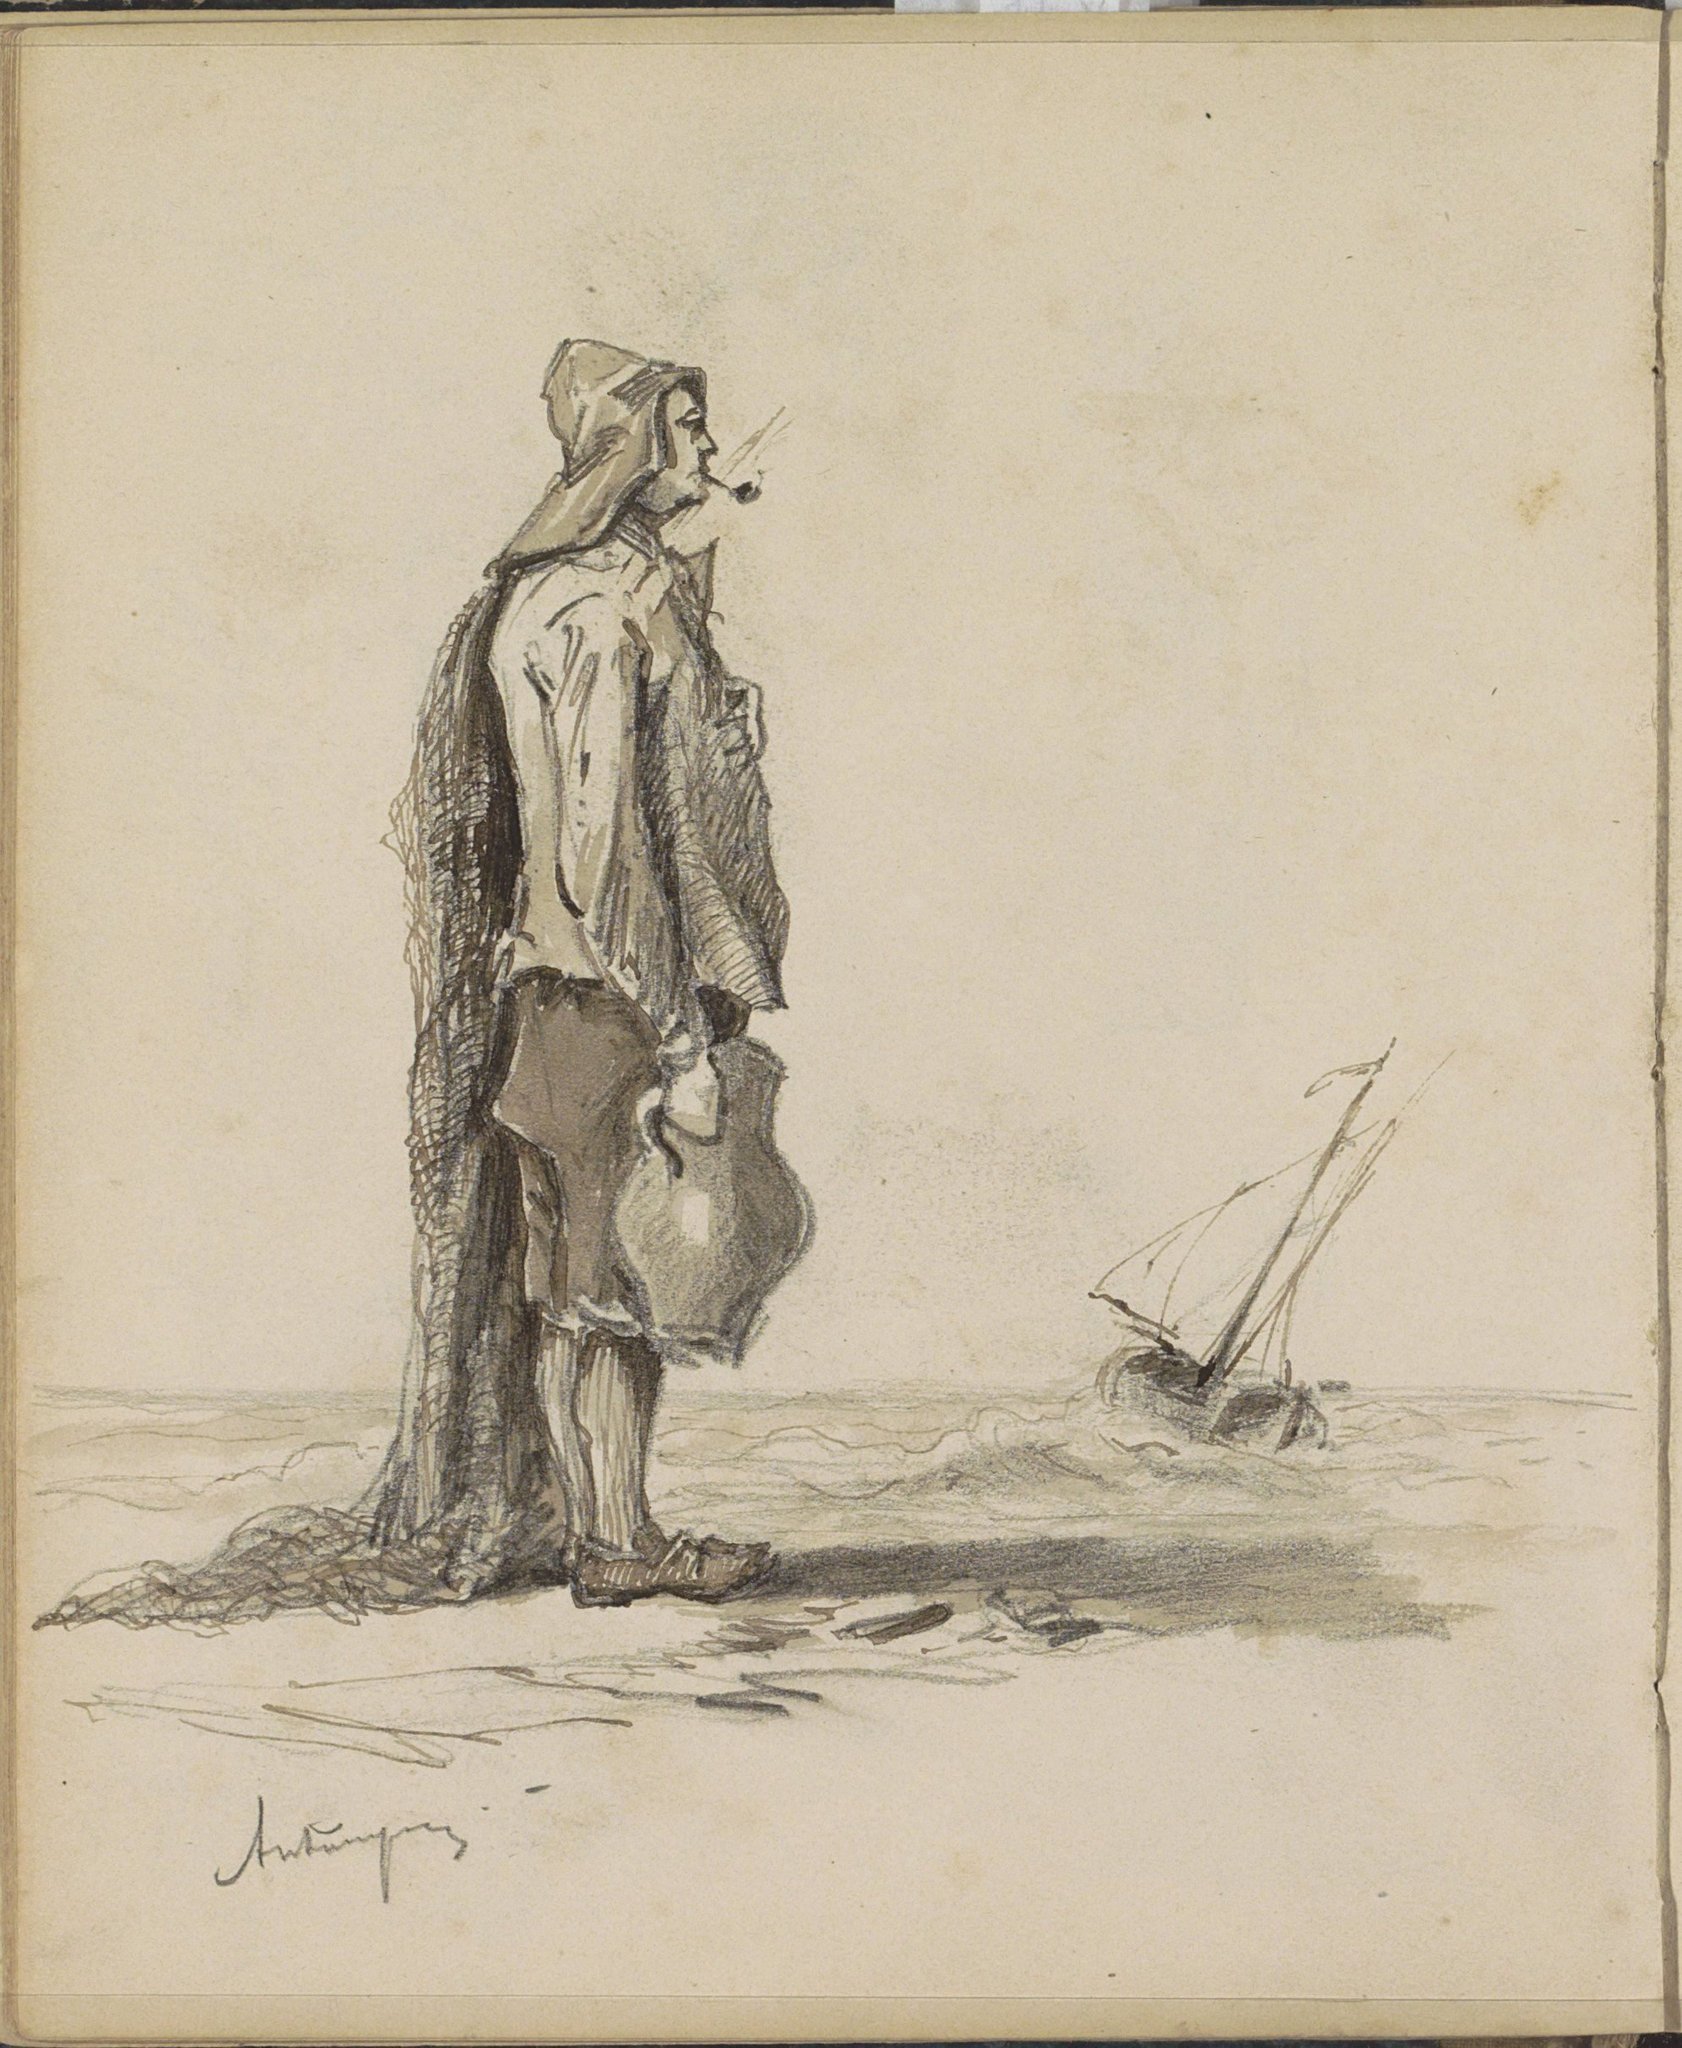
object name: sketchbook leaf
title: Man uitkijkend over een zee met een zeilschip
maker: johannes tavenraat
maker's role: draughtsman, painter, print maker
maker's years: 1809-1881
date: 1841-1853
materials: ink, paper, pencil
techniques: brush, pen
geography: antwerp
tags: standing figure, sailing-ship, sailing-boat, pipe ~ tobacco, sea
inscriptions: annotation: ‘Antwerpen’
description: Blad 65 verso uit een schetsboek met 87 bladen.